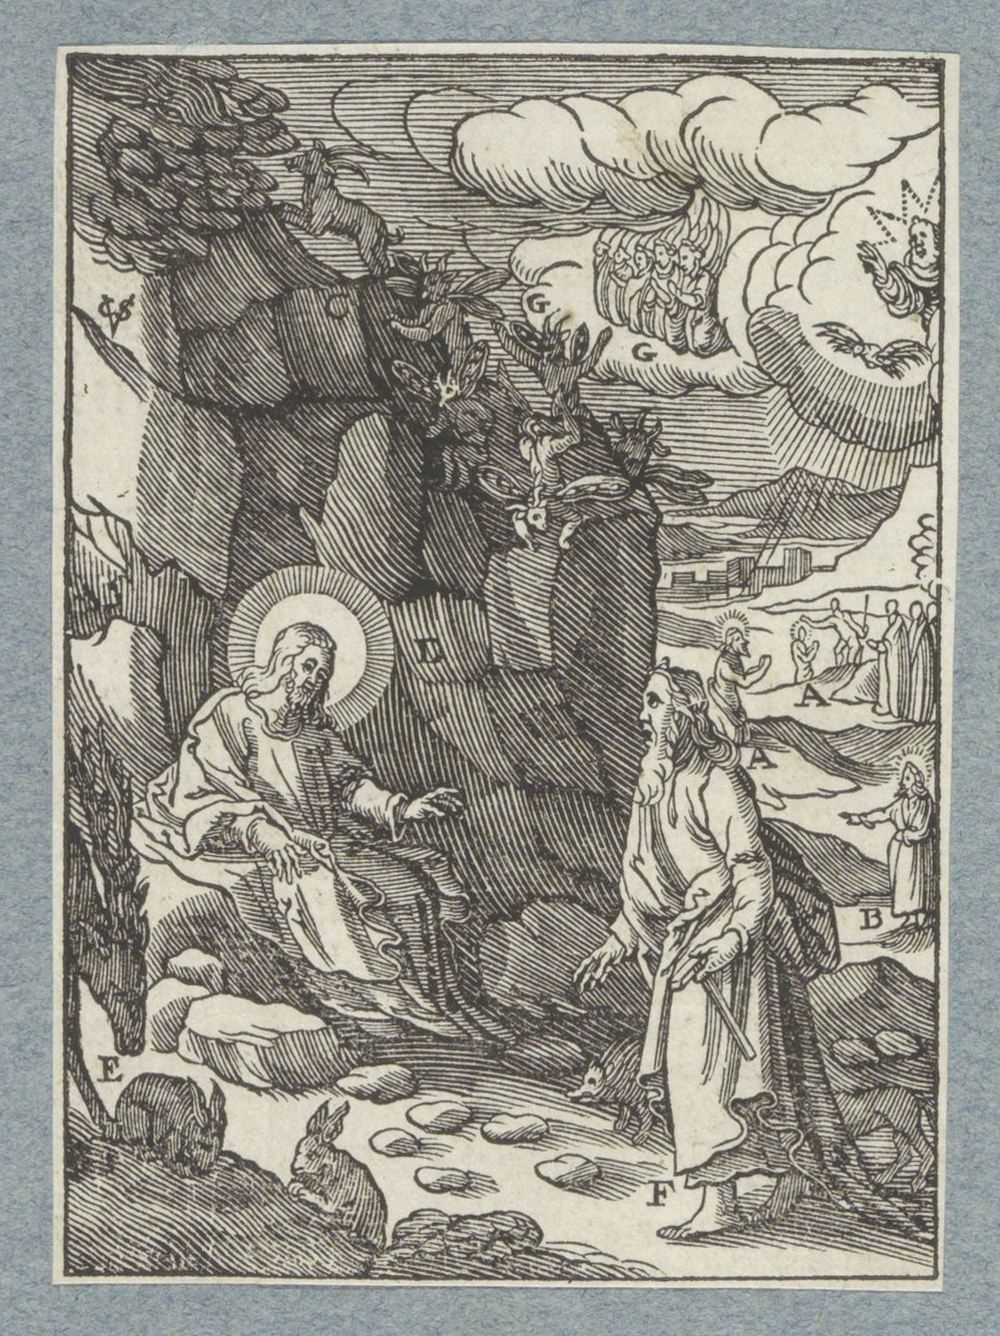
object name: book illustration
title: Christus in de wildernis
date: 1629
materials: paper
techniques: letterpress printing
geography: amsterdam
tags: 'command these stones to become loaves of bread' ~ temptation of christ in the wilderness, christ praying (in general), e.g.: in the wilderness, holy ghost represented as a dove (in flames)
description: De prent is afkomstig uit een van de uitgaven van P.J. Paets uit Amsterdam. De prent wordt voor het eerst gebruikt in: Der Zielen Lust-hof. Leuven, I.Jacbosz voor P.J. Paets [= Amsterdam, P.J. Paets], 1629. De voorstelling is gekopieerd naar een prent van Hieronymus Wierix voor: Nadal, Jerónimo. Evangelicae Historiae Imagines. Antwerpen, M. Nutius, 1593.